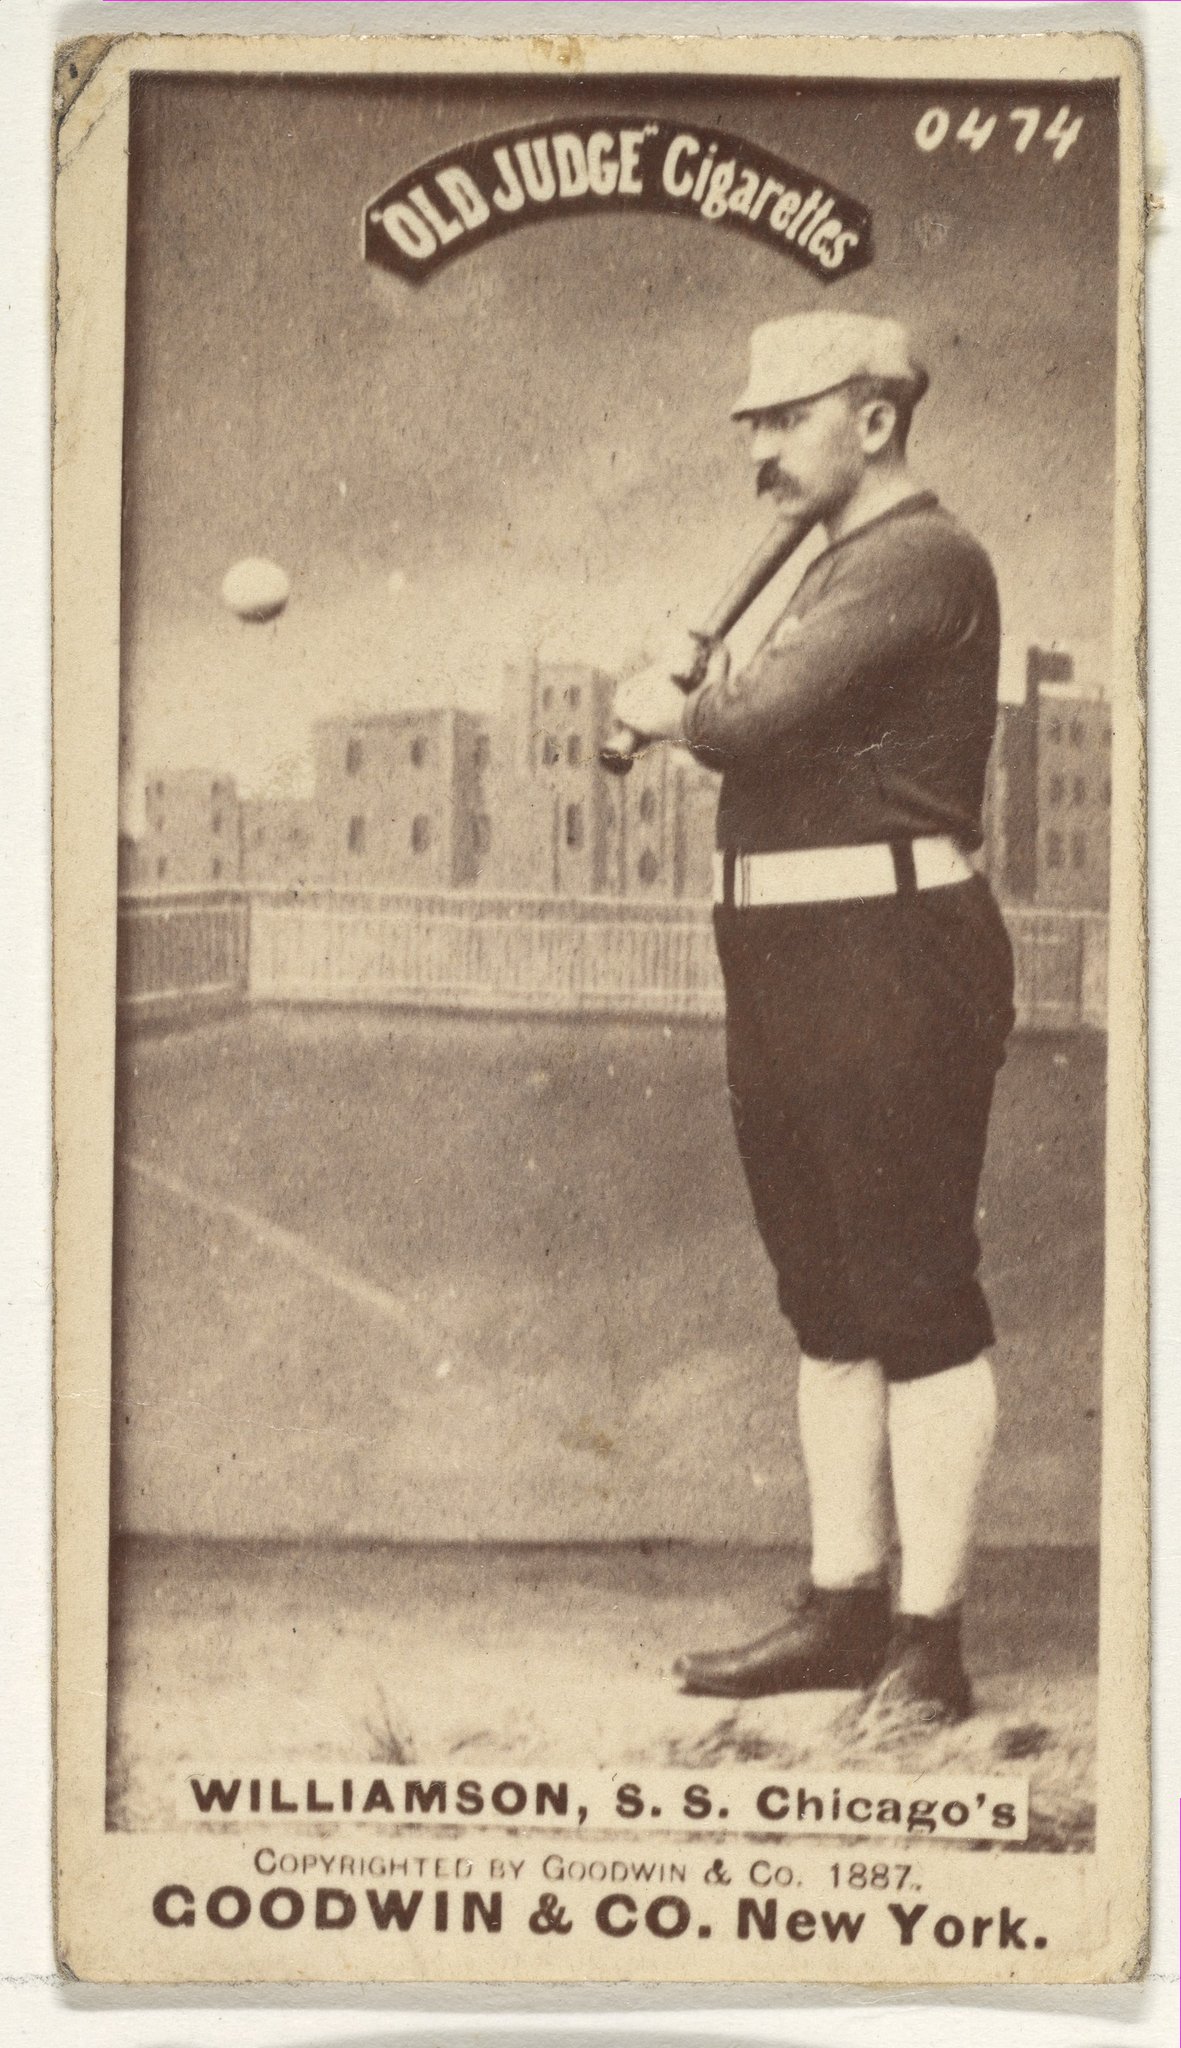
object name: baseball card, photograph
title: Williamson, Shortstop, Chicago, from the Old Judge series (N172) for Old Judge Cigarettes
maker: goodwin & company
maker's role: publisher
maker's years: 1850-1950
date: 1887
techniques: albumen silver print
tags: men,portraits,baseball,athletes